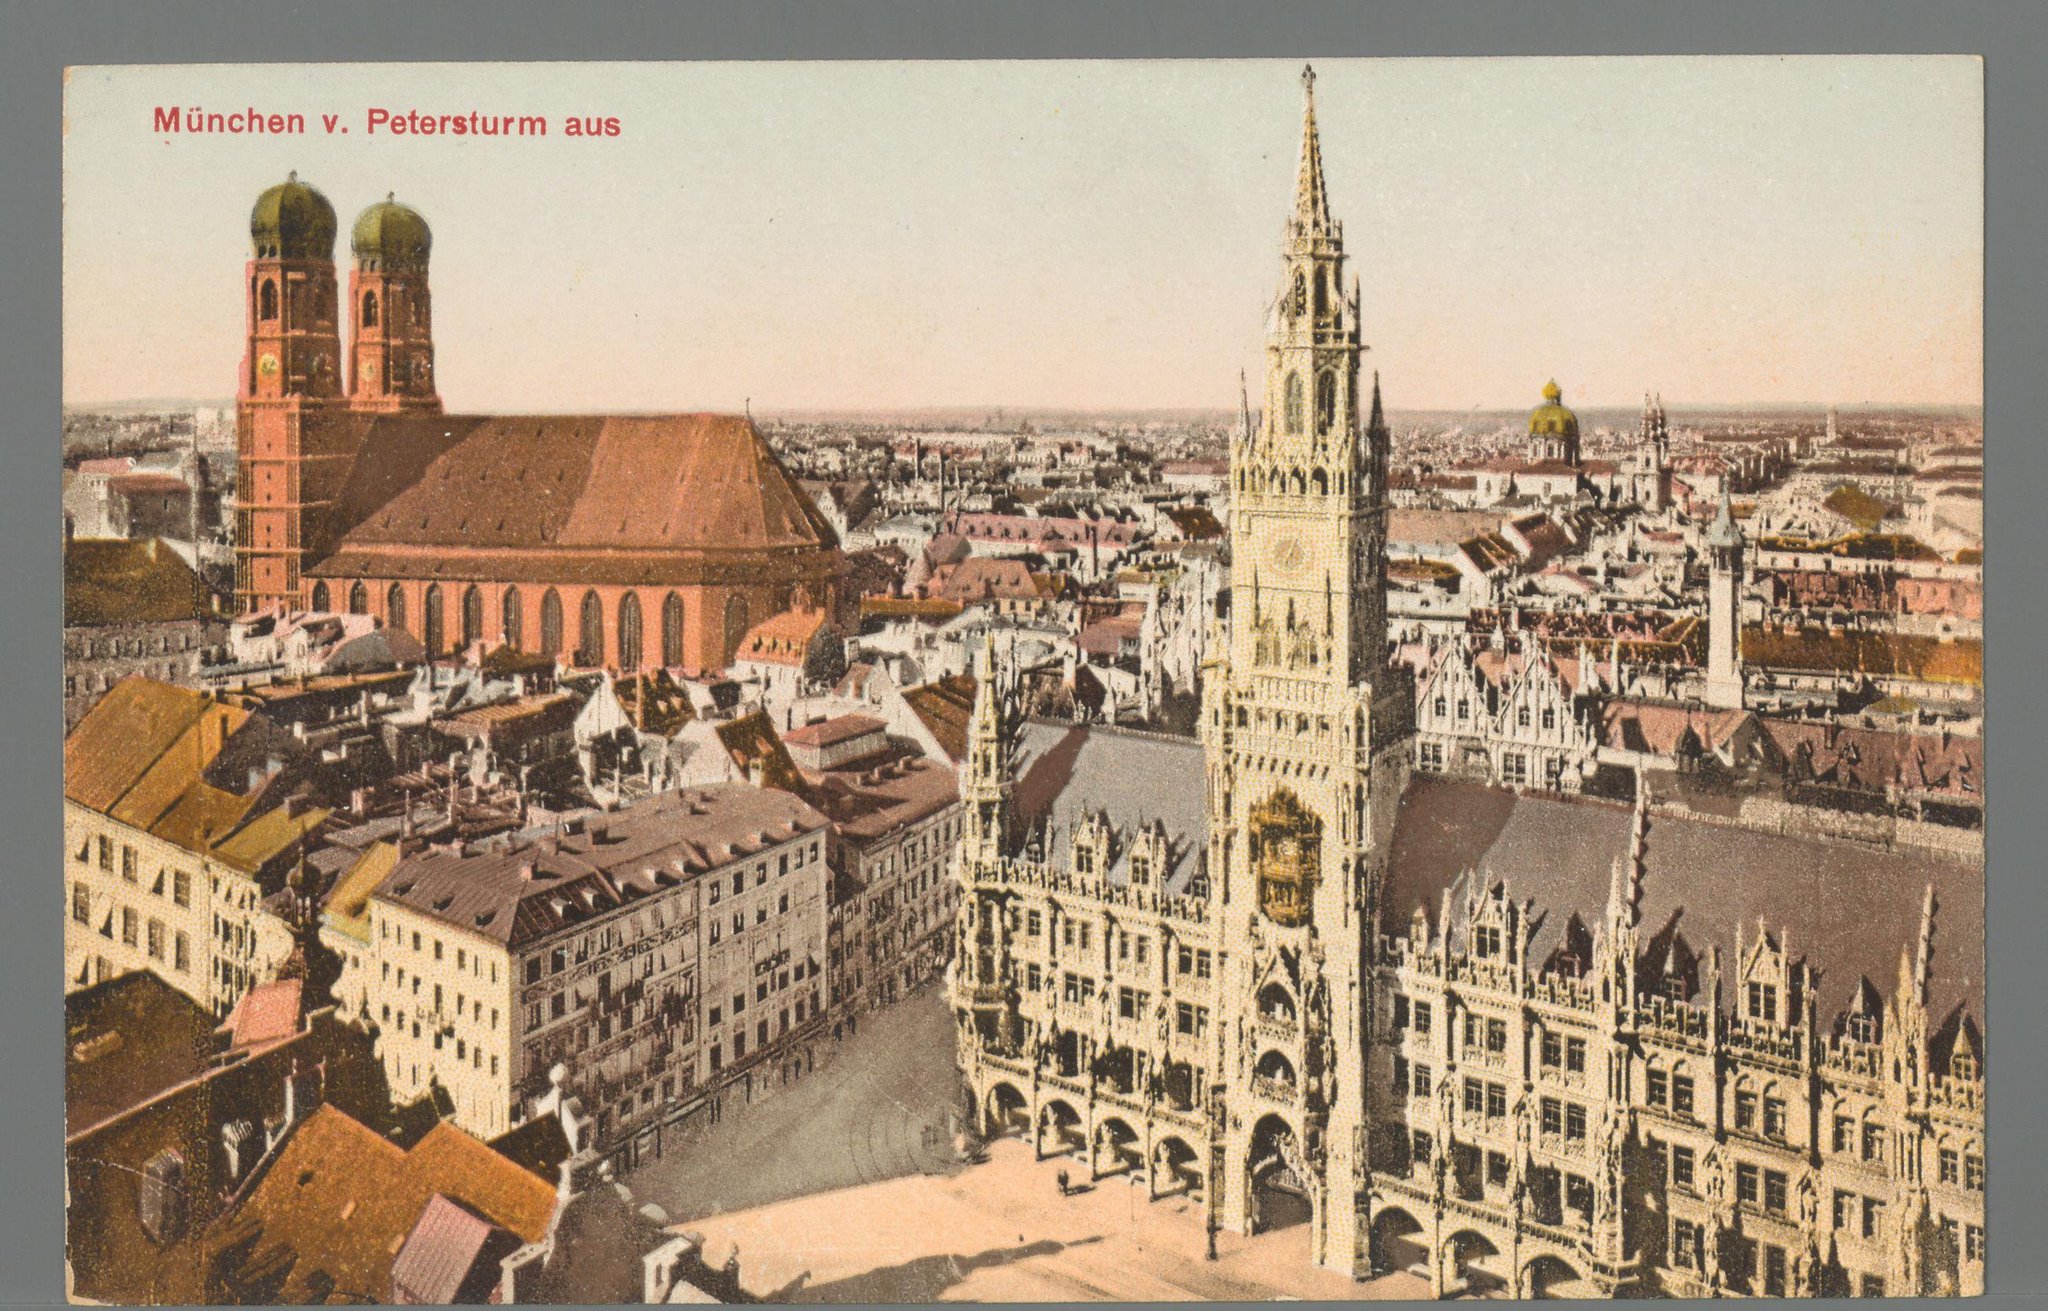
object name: ansichtkaart, prentbriefkaart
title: München v. Petersturm aus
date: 1905-1930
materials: cardboard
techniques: lithograph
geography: munich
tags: city-view, and landscape with man-made constructions, church (exterior), townhall